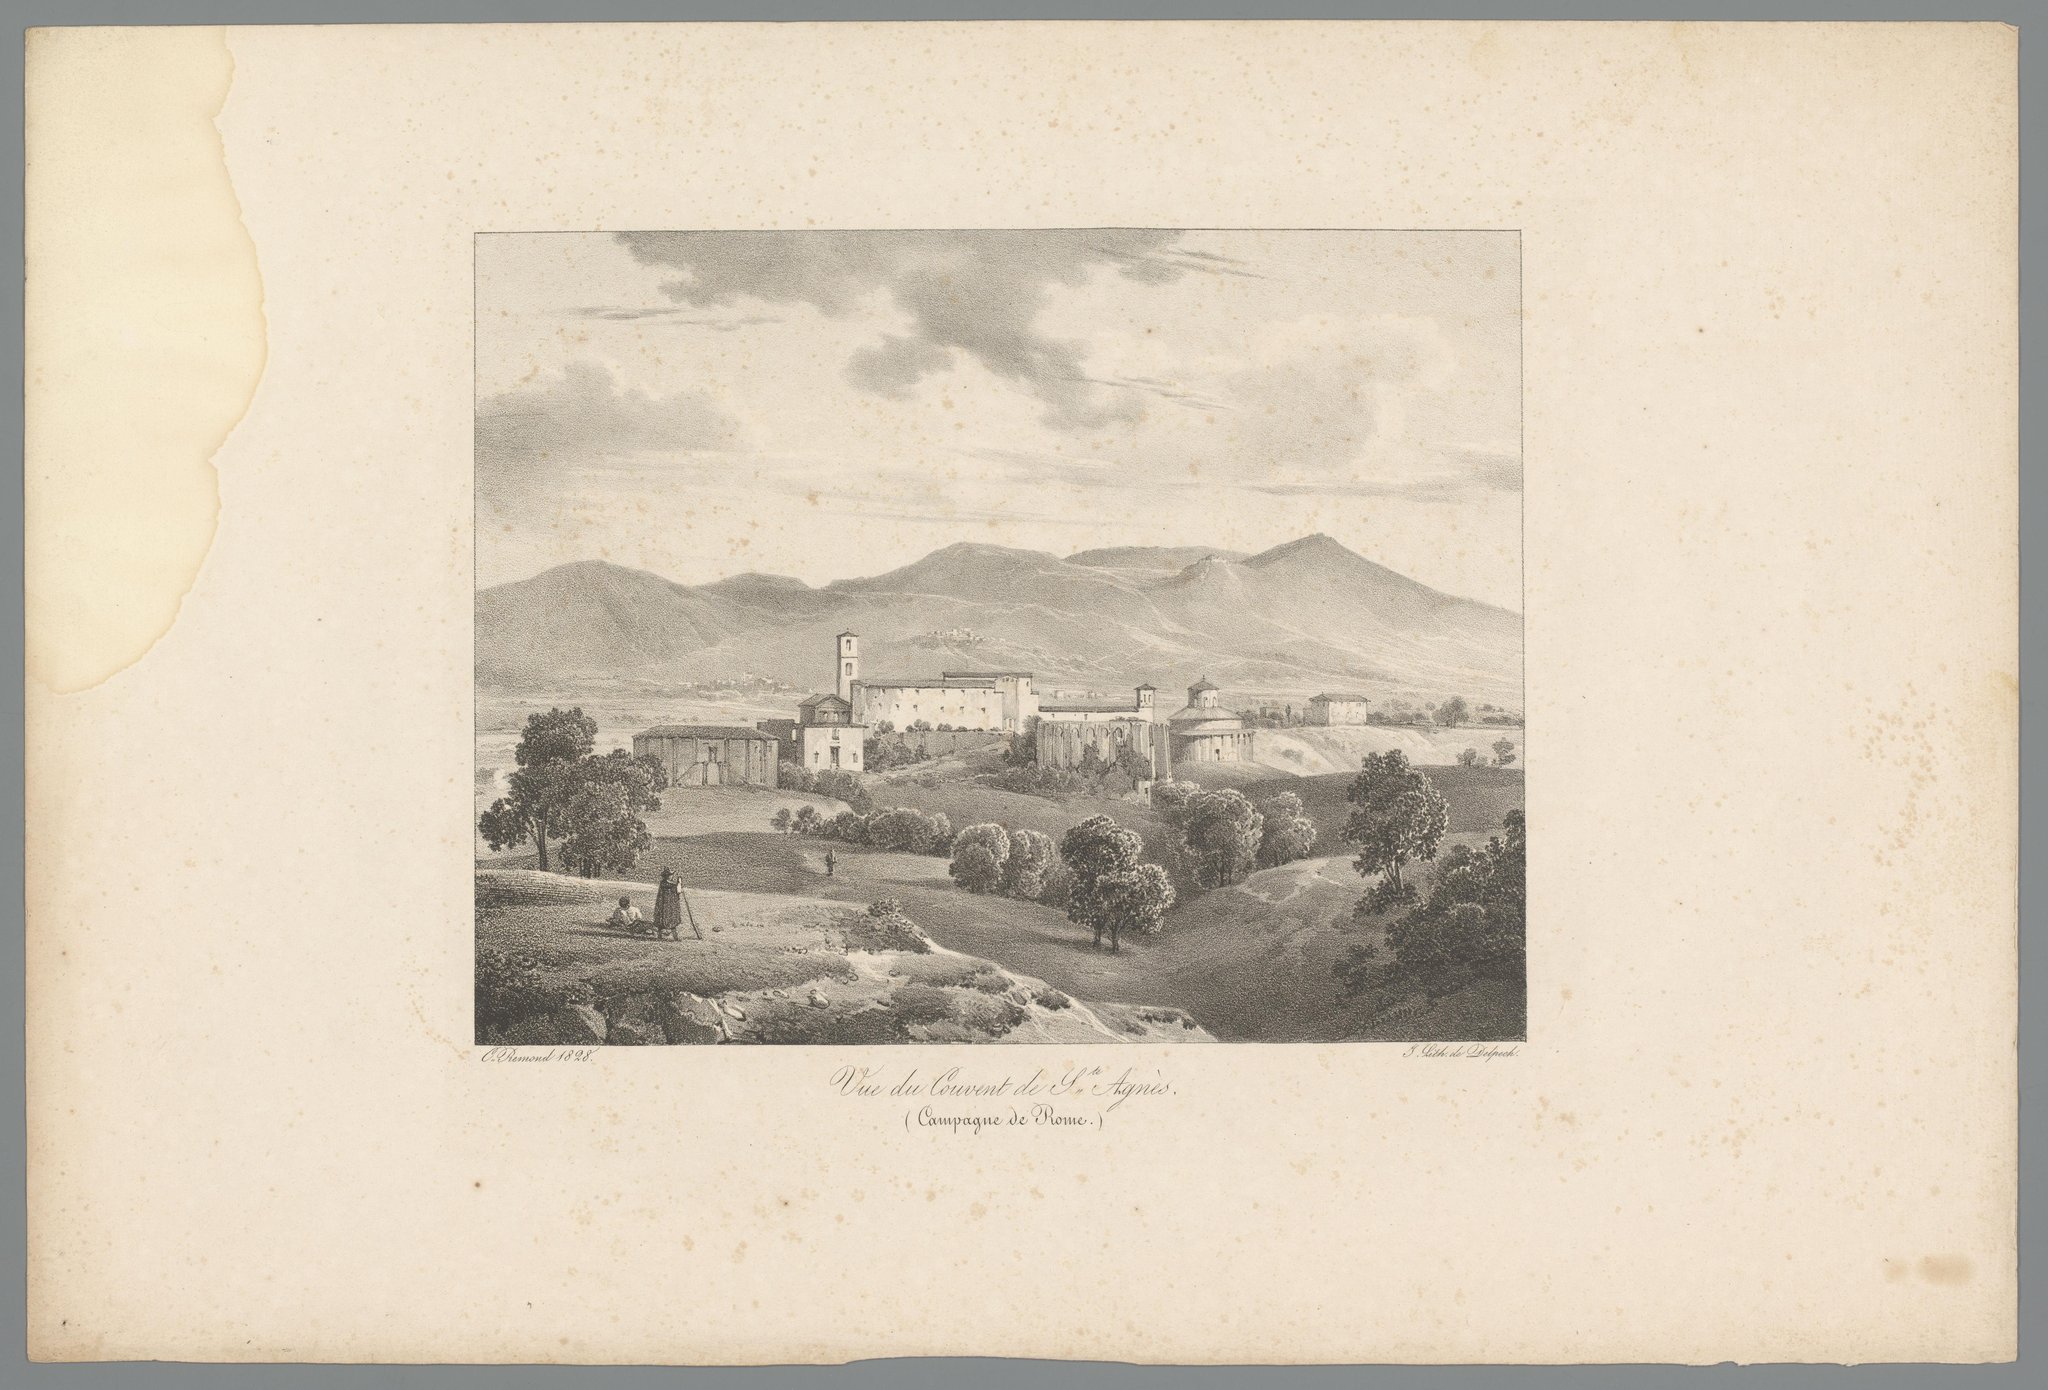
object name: print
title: Gezichten van Italië door Charles Rémond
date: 1828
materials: paper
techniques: lithograph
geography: paris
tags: landscapes, abbey, monastery, convent ~ roman catholic church, rome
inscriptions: collector's mark: Lugt 2228